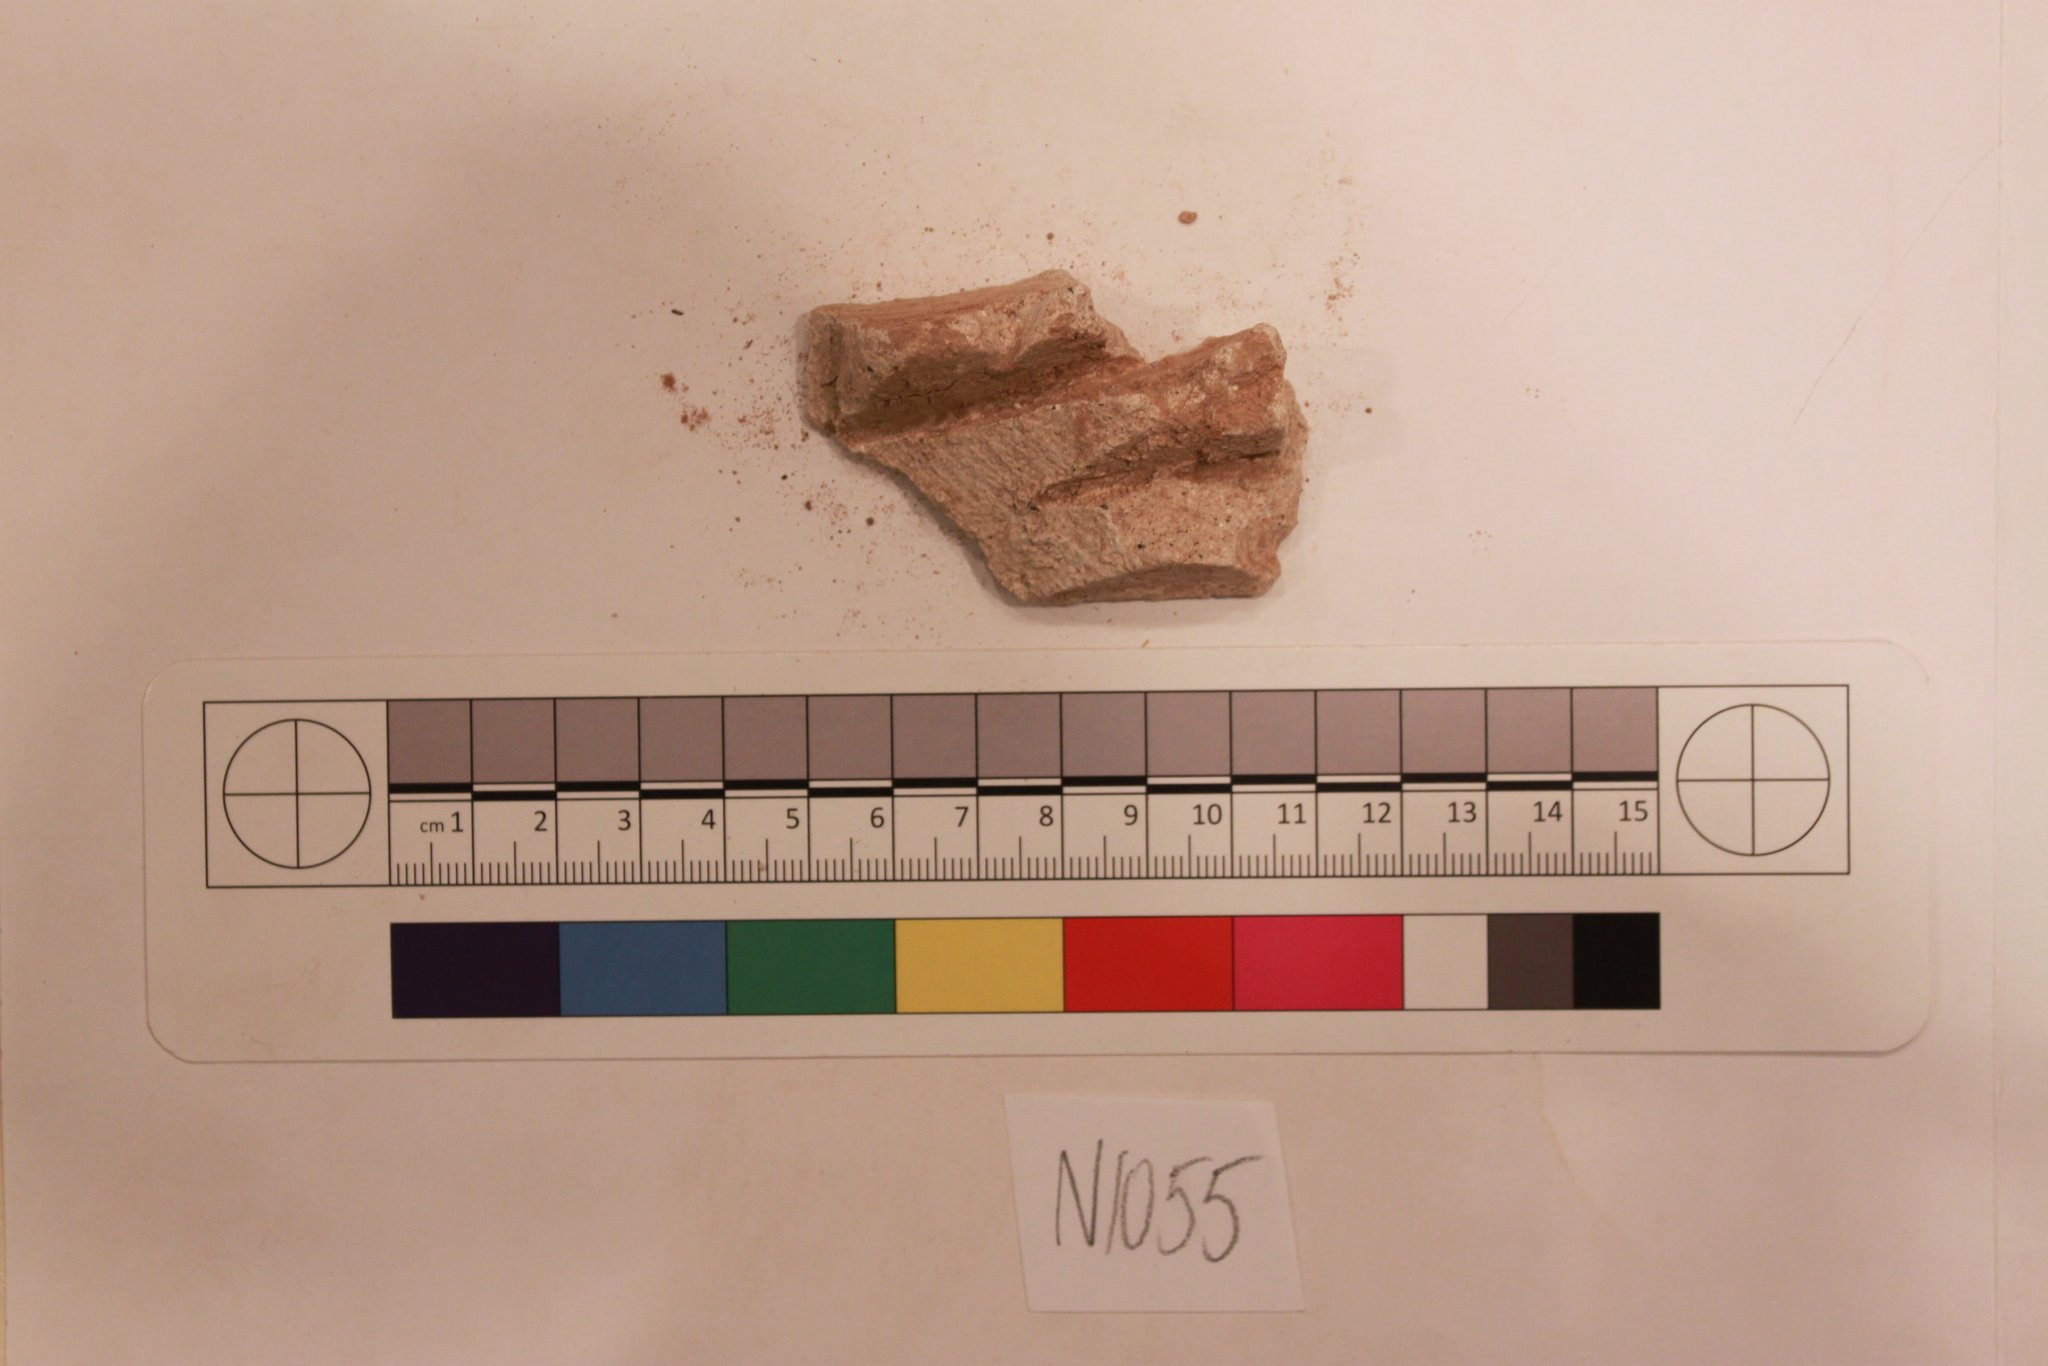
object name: fragment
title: Stucco Fragment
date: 701-1200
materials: plaster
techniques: carving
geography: iran